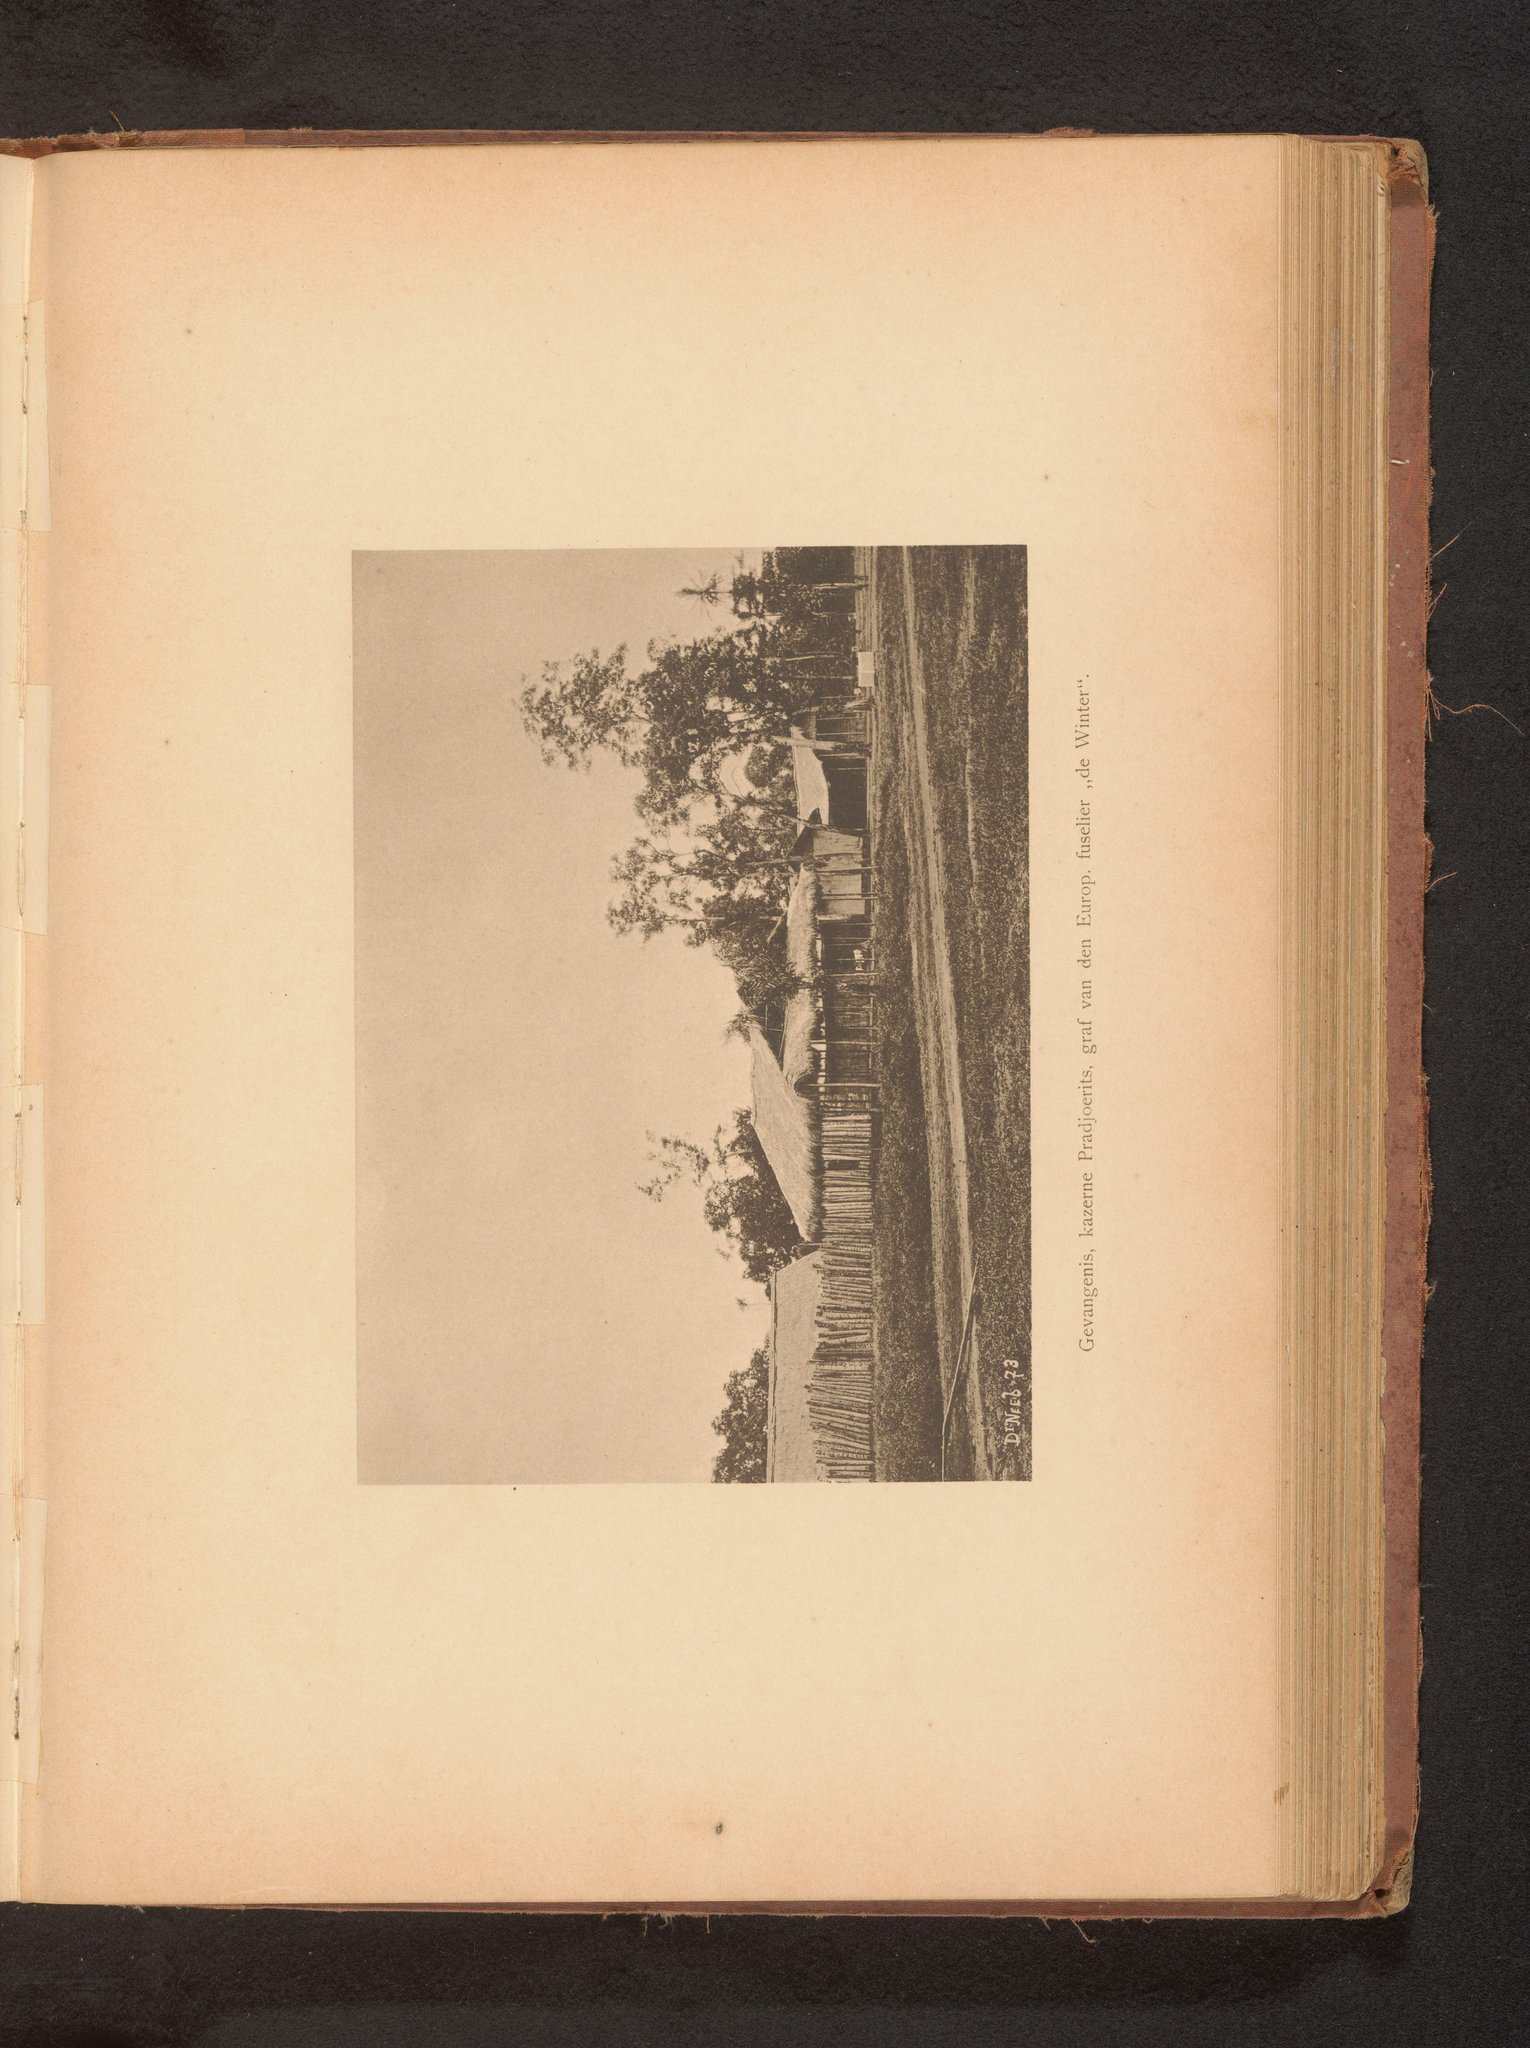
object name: page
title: Gezicht op de kazerne Pradjoerits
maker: christiaan johan neeb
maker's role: arts, fotograaf, officier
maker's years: 1860-1925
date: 1892-1897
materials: paper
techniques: photograph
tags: barracks, indonesia